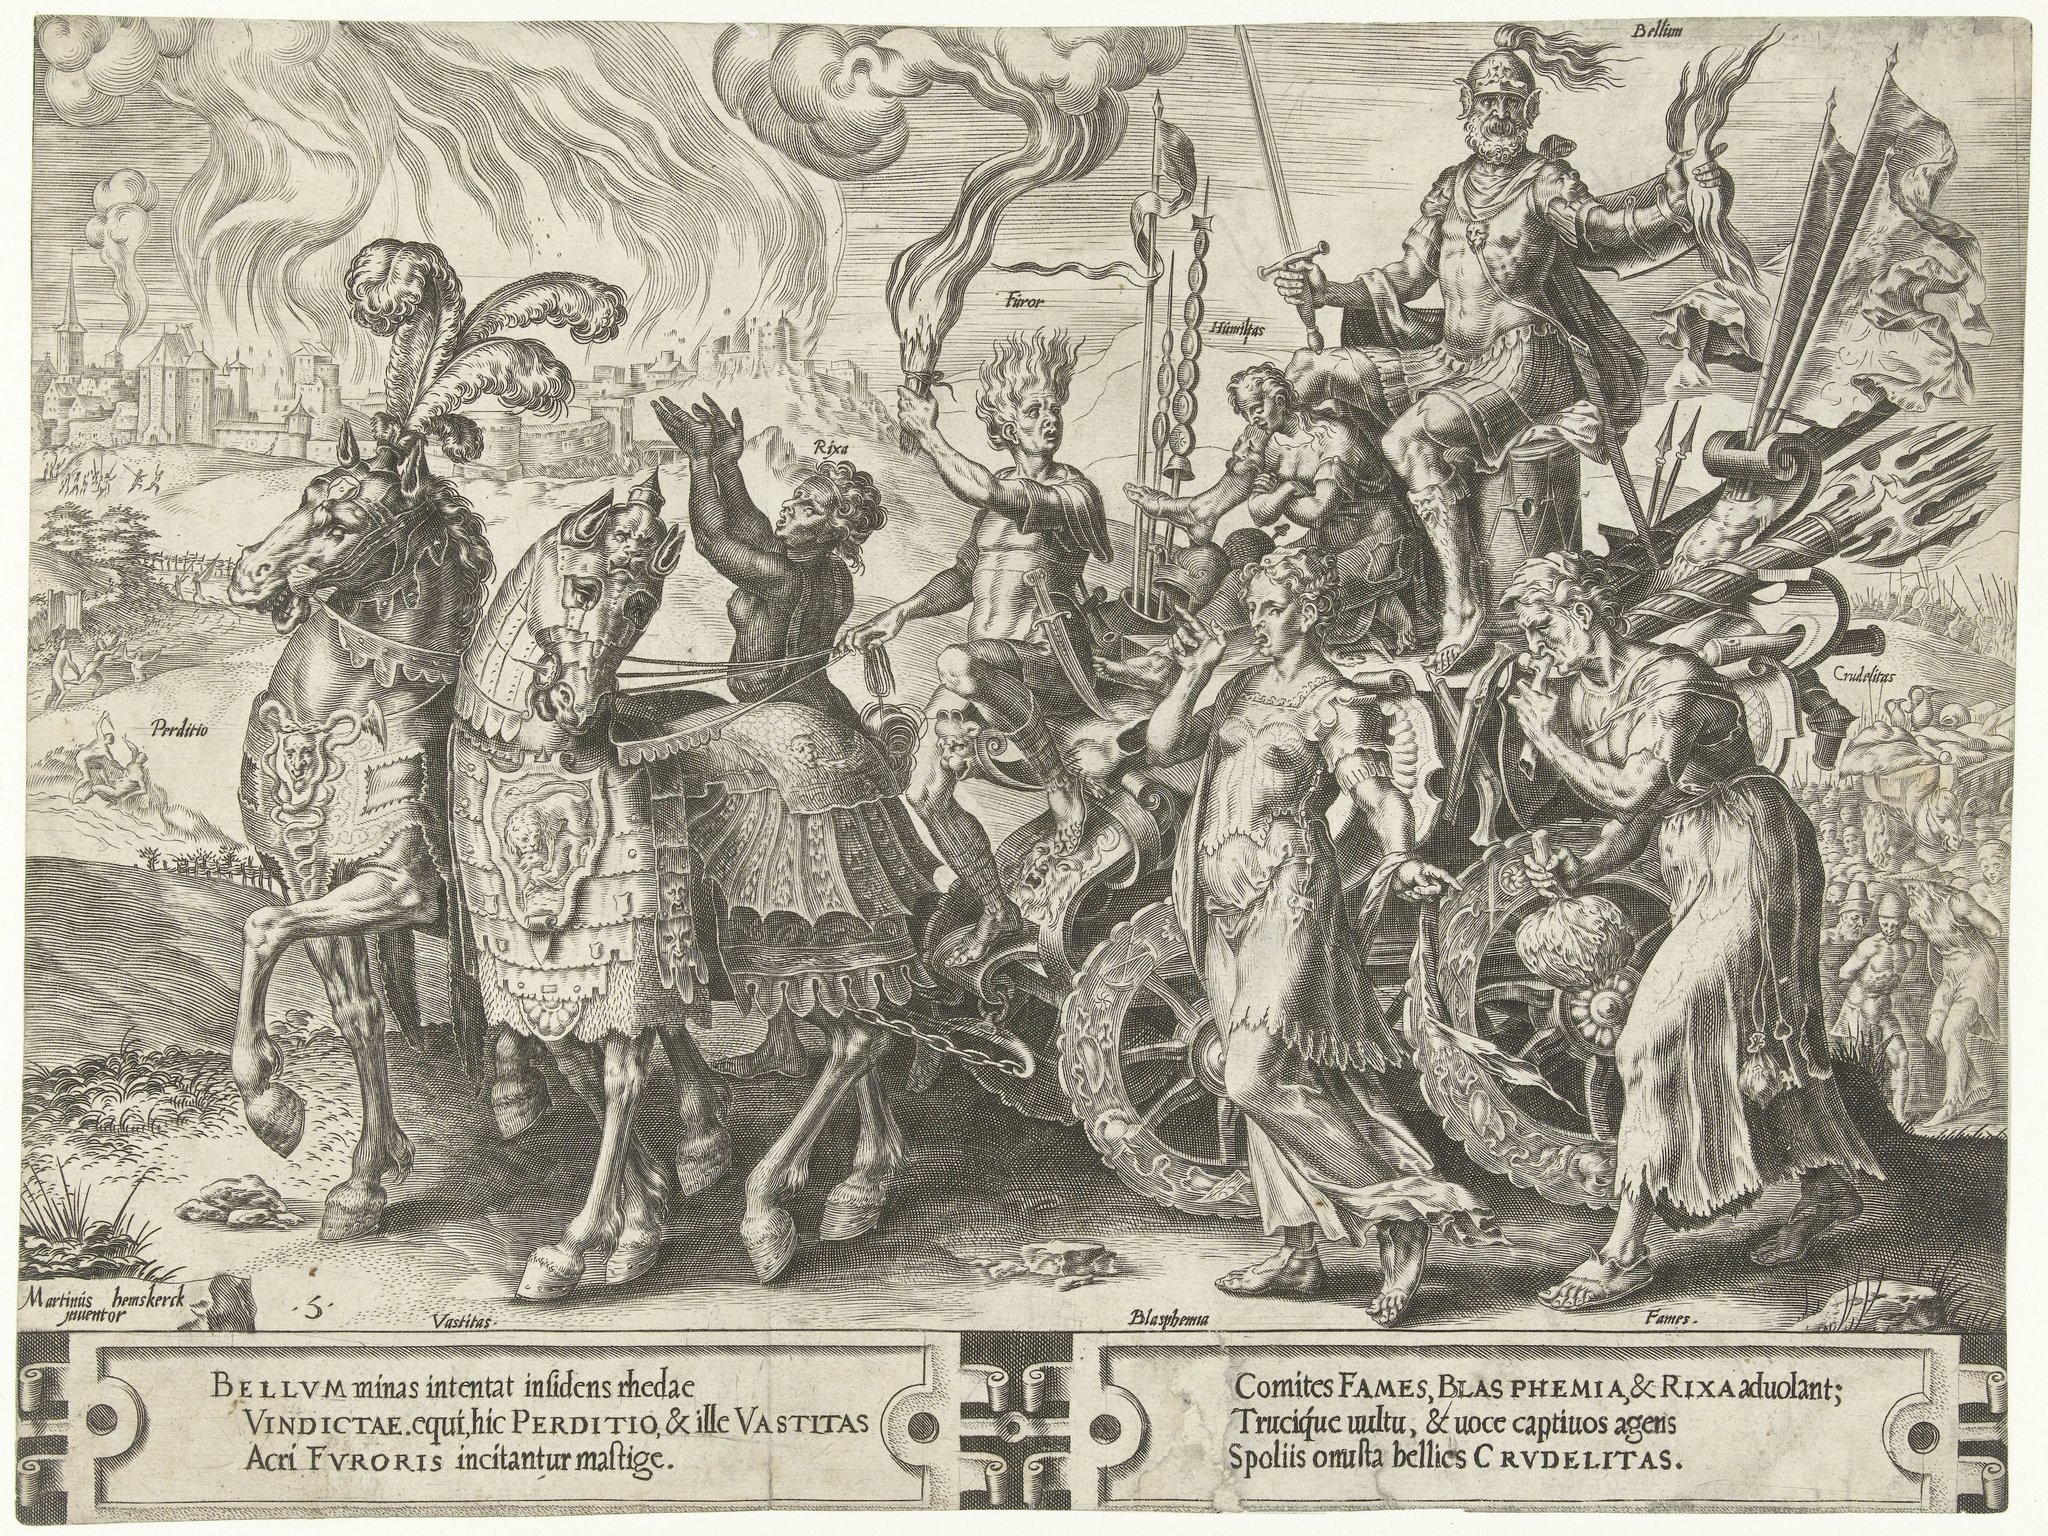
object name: print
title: Triomfwagen met Oorlog (Bellum)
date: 1564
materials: paper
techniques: engraving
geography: antwerp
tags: vicissitudes of life (+ allegorical scene, i.e. two or more personifications involved in an action), allegory, personification of destruction of conquered city, setting on fire (of conquered city), symbols, allegories of war; 'guerra' (ripa), prisoner of war (after the battle)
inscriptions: collector's mark: Lugt 2228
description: Een man met een bliksemschicht en zwaard in zijn hand, de personificatie van de oorlog, rijdt op een triomfwagen langs een brandende stad. Achter de wagen lopen soldaten en gevangenen aan. Naast de wagen lopen andere personificaties, zoals Laster en Honger. Aan de voeten van Oorlog knielt de personificatie van armoede (Inopia), deze wordt op de prent abusievelijk Humilitas (Nederigheid) genoemd. Prent uit een serie van negen prenten met triomfwagens uit de Antwerpse Besnijdenis-ommegang van 1561. De personificaties op de wagens verbeelden samen de kringloop van het menselijk handelen.